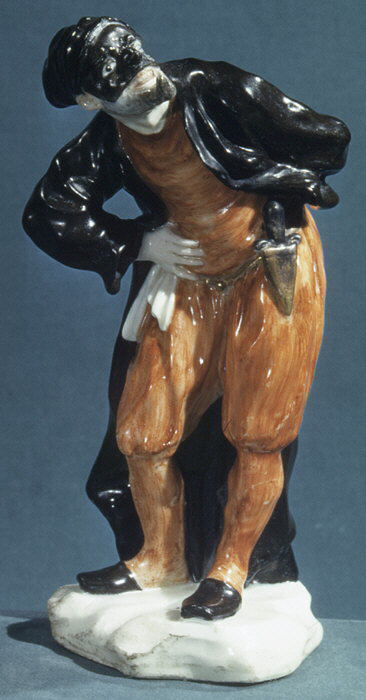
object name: figure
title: Pantaloon (one of a pair)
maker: capodimonte porcelain manufactory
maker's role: manufactory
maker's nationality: italian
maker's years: 1740-1759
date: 1750-1752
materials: soft paste porcelain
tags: men